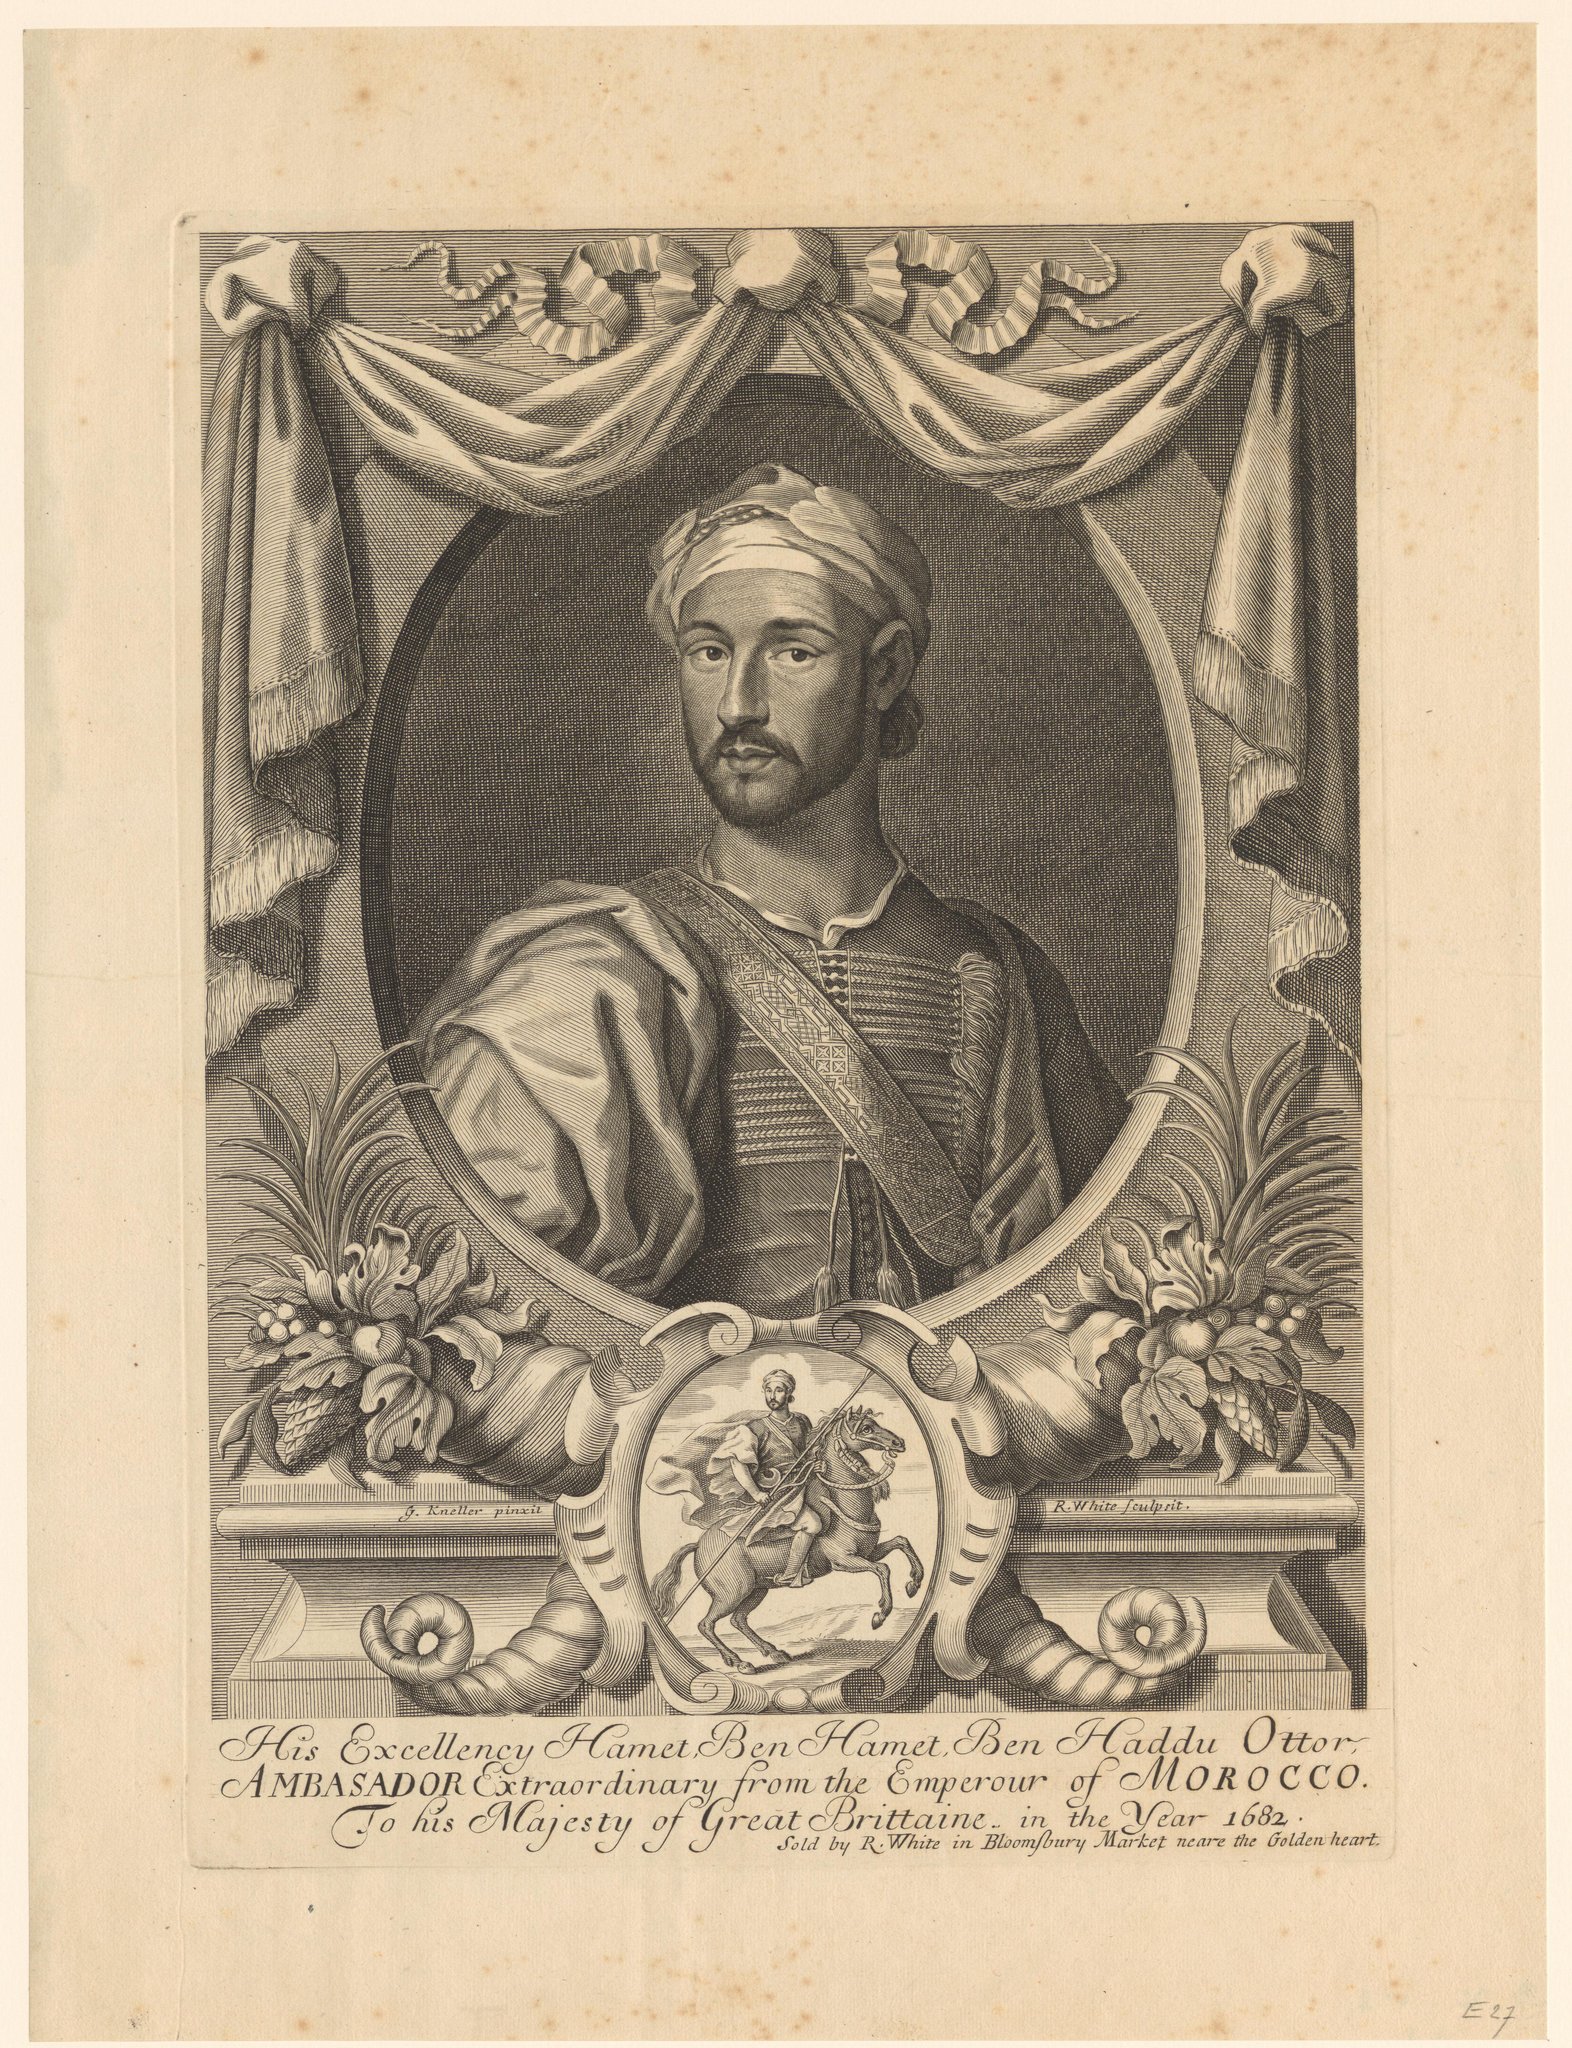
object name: print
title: Portret van Mohammed ben Hadou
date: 1682-1684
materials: paper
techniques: engraving, etching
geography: london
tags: historical persons, ambassador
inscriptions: collector's mark: Lugt 11